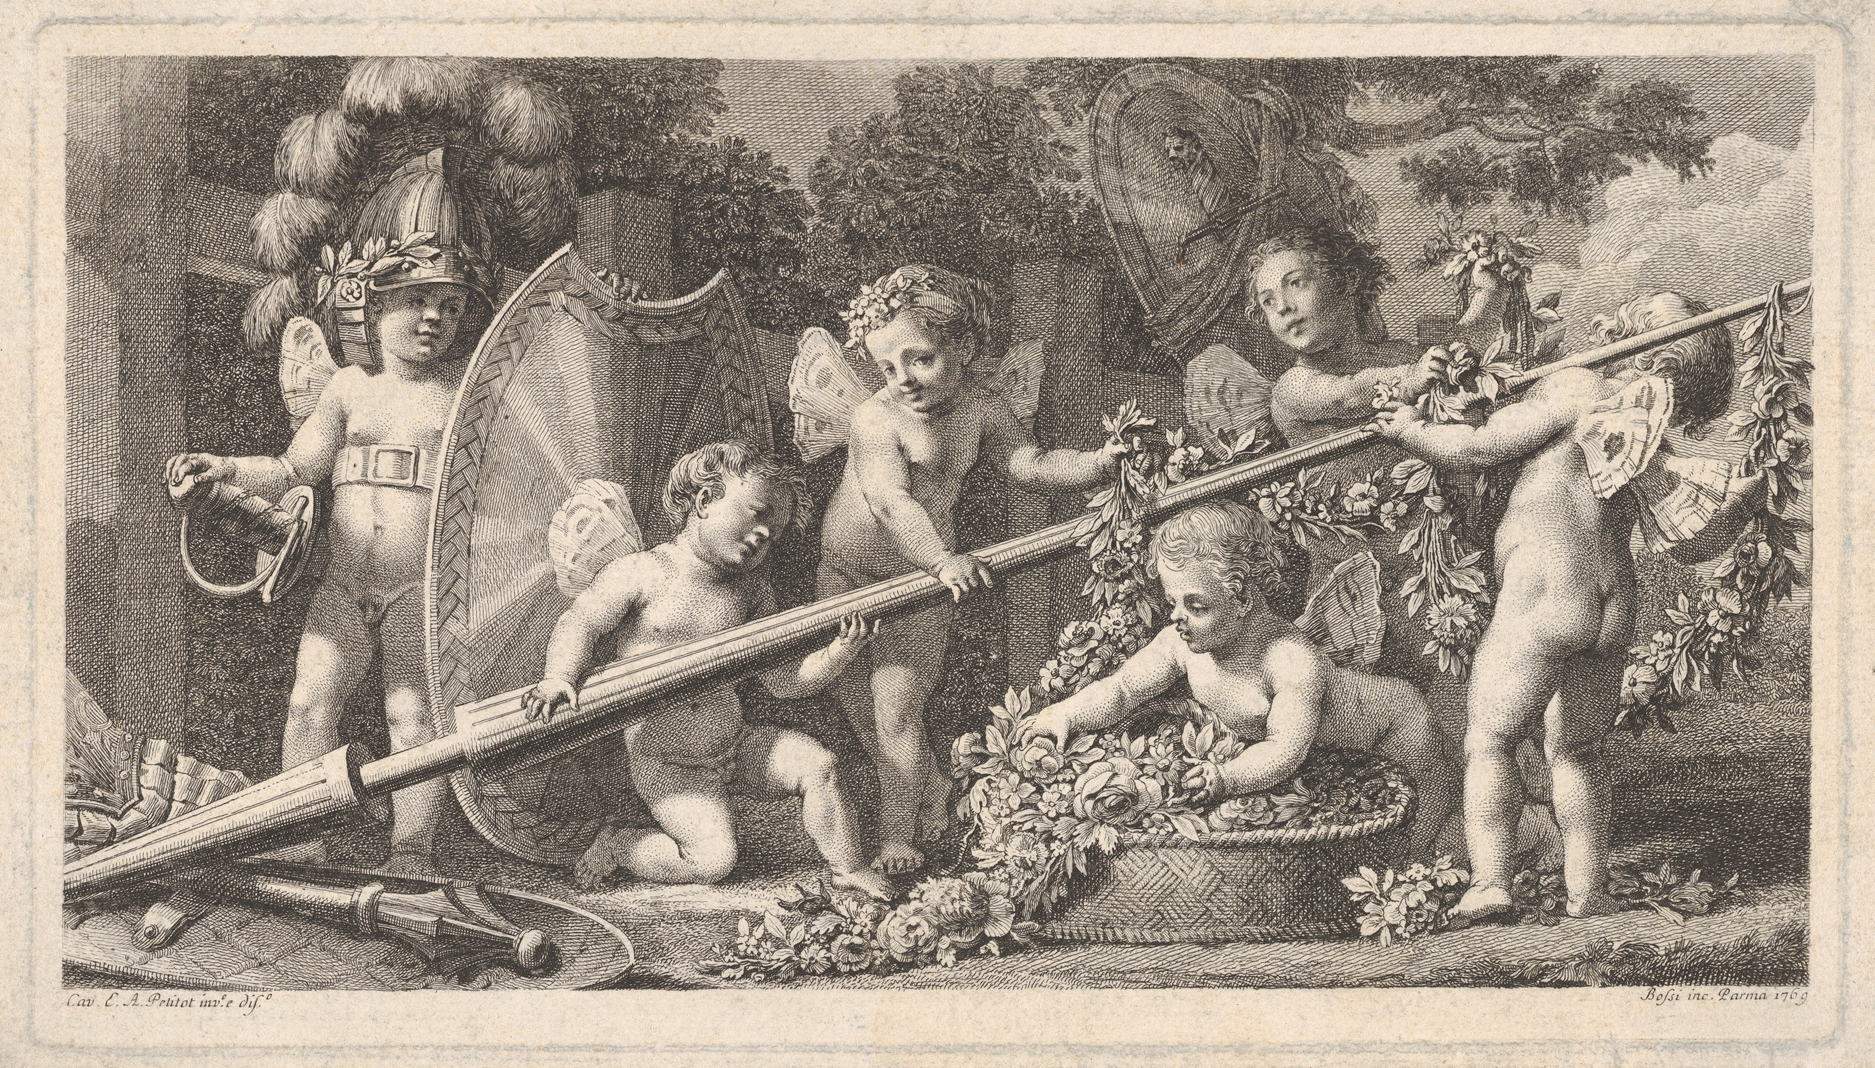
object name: print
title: Six putti playing with the arms of Mars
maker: benigno bossi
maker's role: artist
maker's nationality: italian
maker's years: 1727-1792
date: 1769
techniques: engraving, etching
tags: helmets,shields,putti